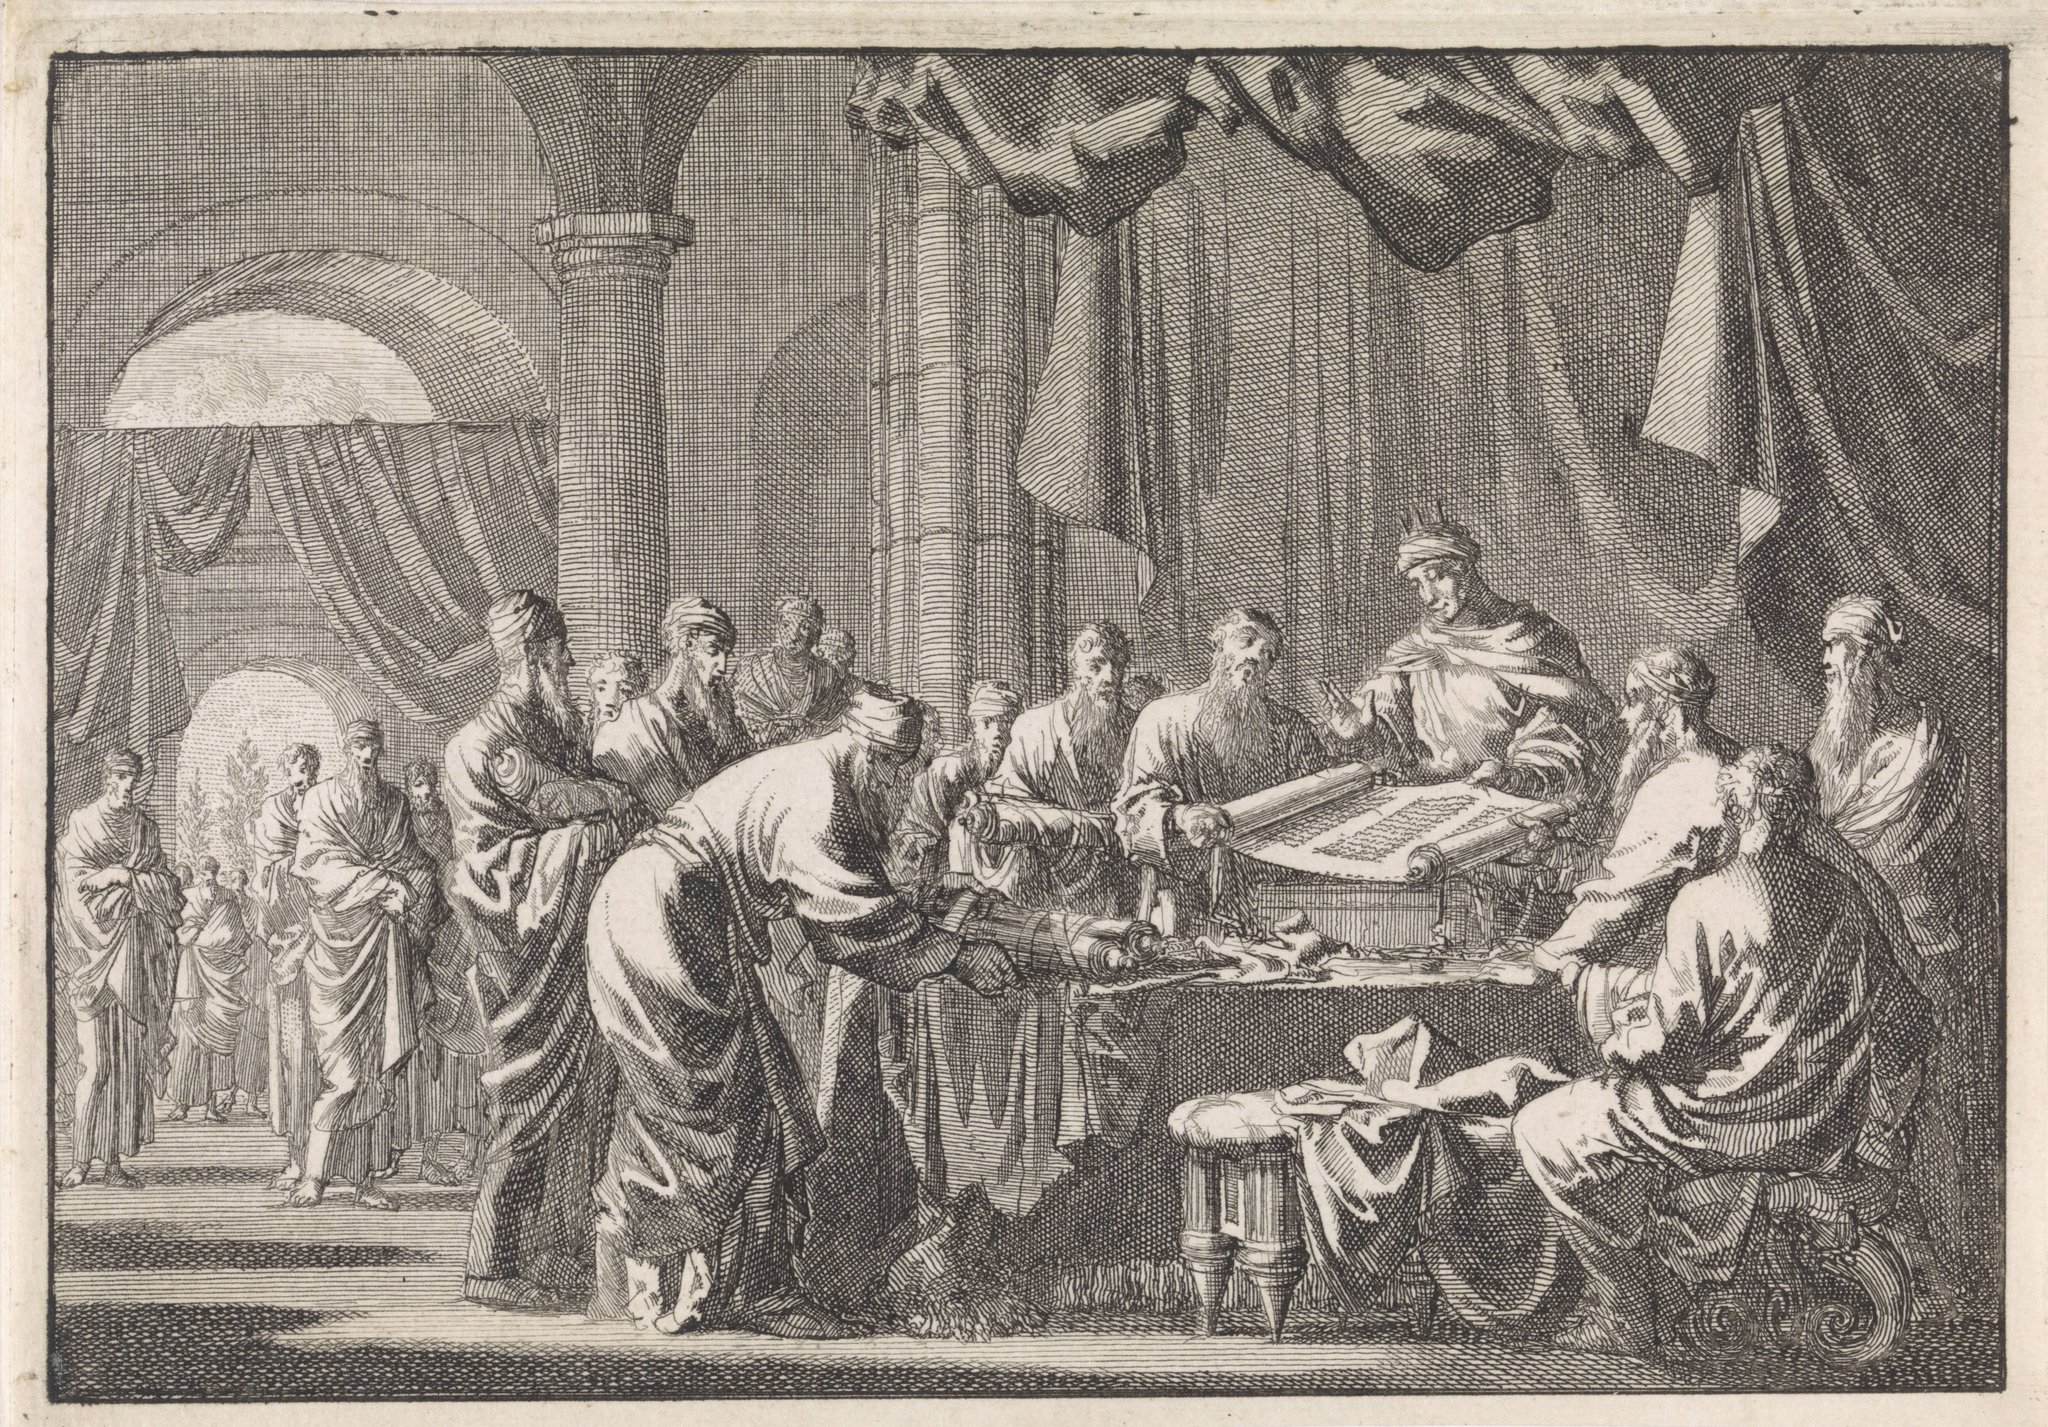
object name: print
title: Bijeenkomst van de 72 vertalers van de wet op bevel van koning Ptolomeüs Philadelphus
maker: jan luyken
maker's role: draughtsman, print maker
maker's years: 1649-1712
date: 1704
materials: paper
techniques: etching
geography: amsterdam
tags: ptolemy philadelphus frees the jewish prisoners of war in reward for the translation of the old testament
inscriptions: collector's mark: Lugt 2228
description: Prent ook gebruikt als boekillustratie in: Josephus, Flavius. Alle de Werken, 2 delen. Amsterdam: Pieter Mortier, 1704, dl. 1, p. 284.